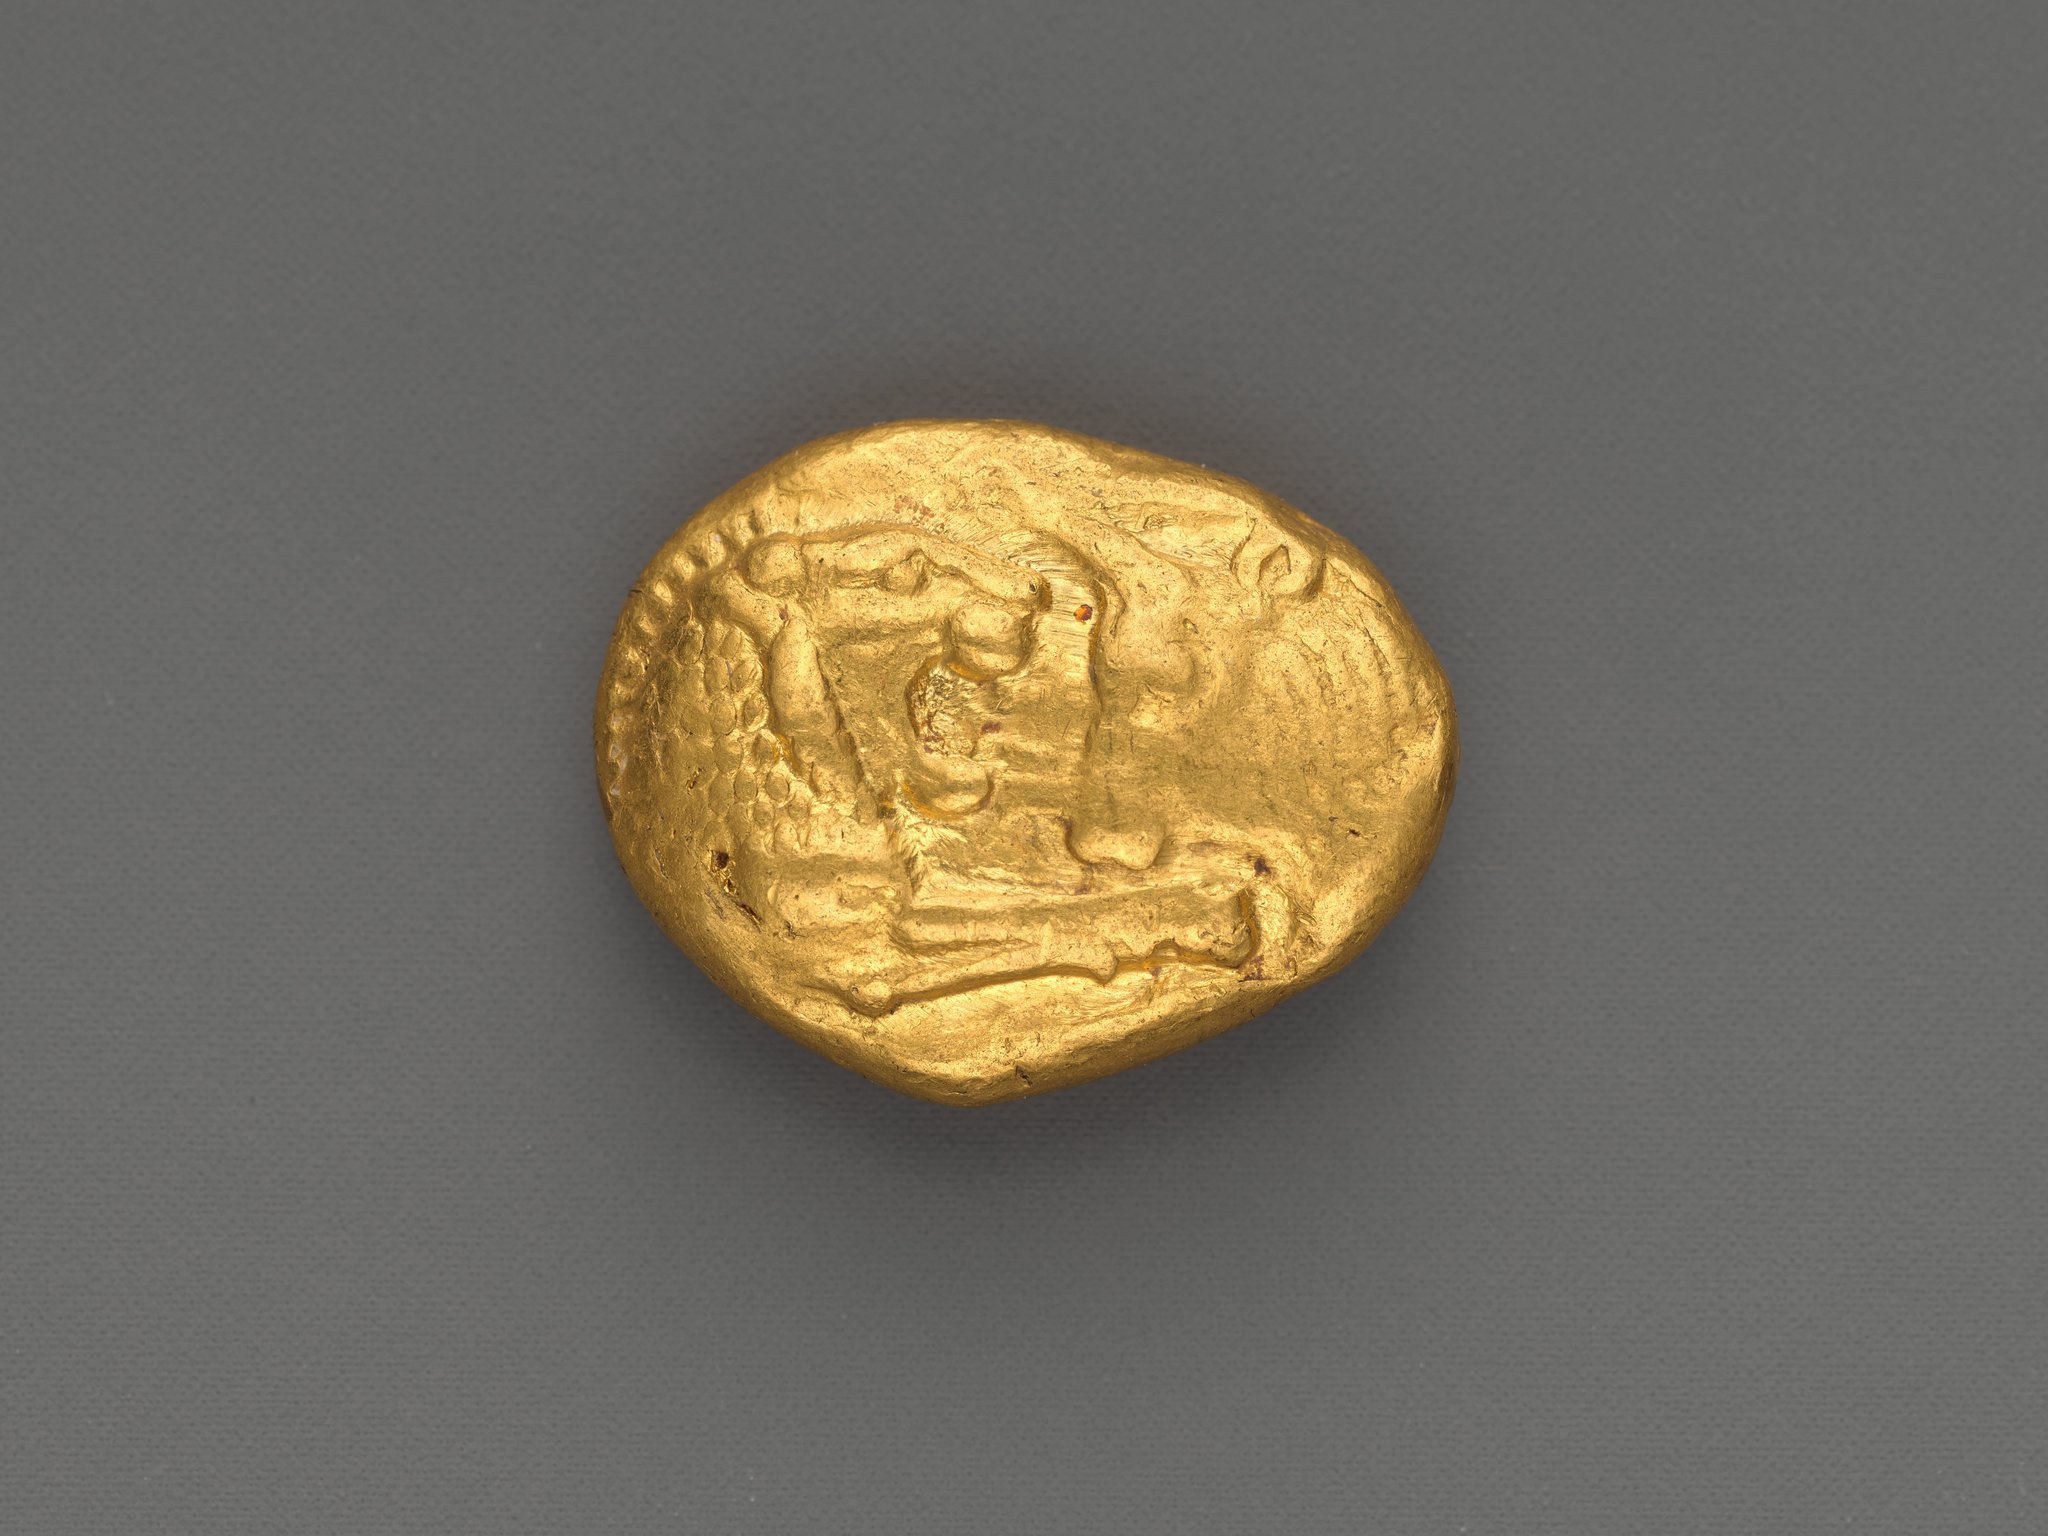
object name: stater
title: Gold stater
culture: lydian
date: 560-546 BCE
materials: gold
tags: bulls,lions